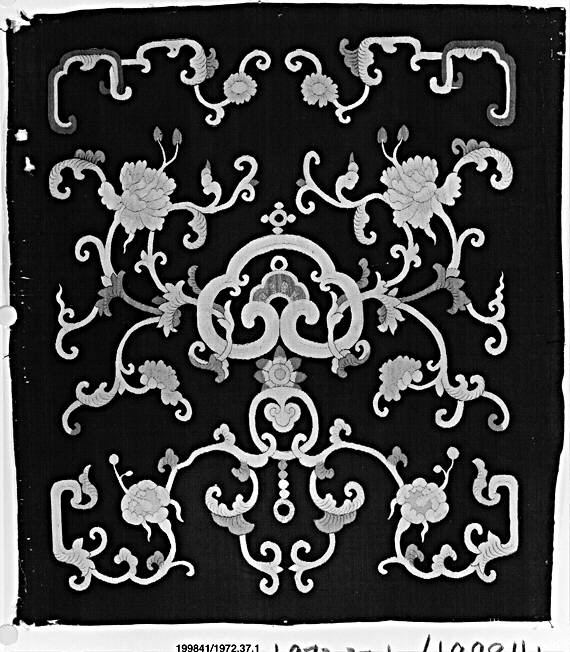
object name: panel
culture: chinese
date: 1601-1800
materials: metal thread, silk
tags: flowers